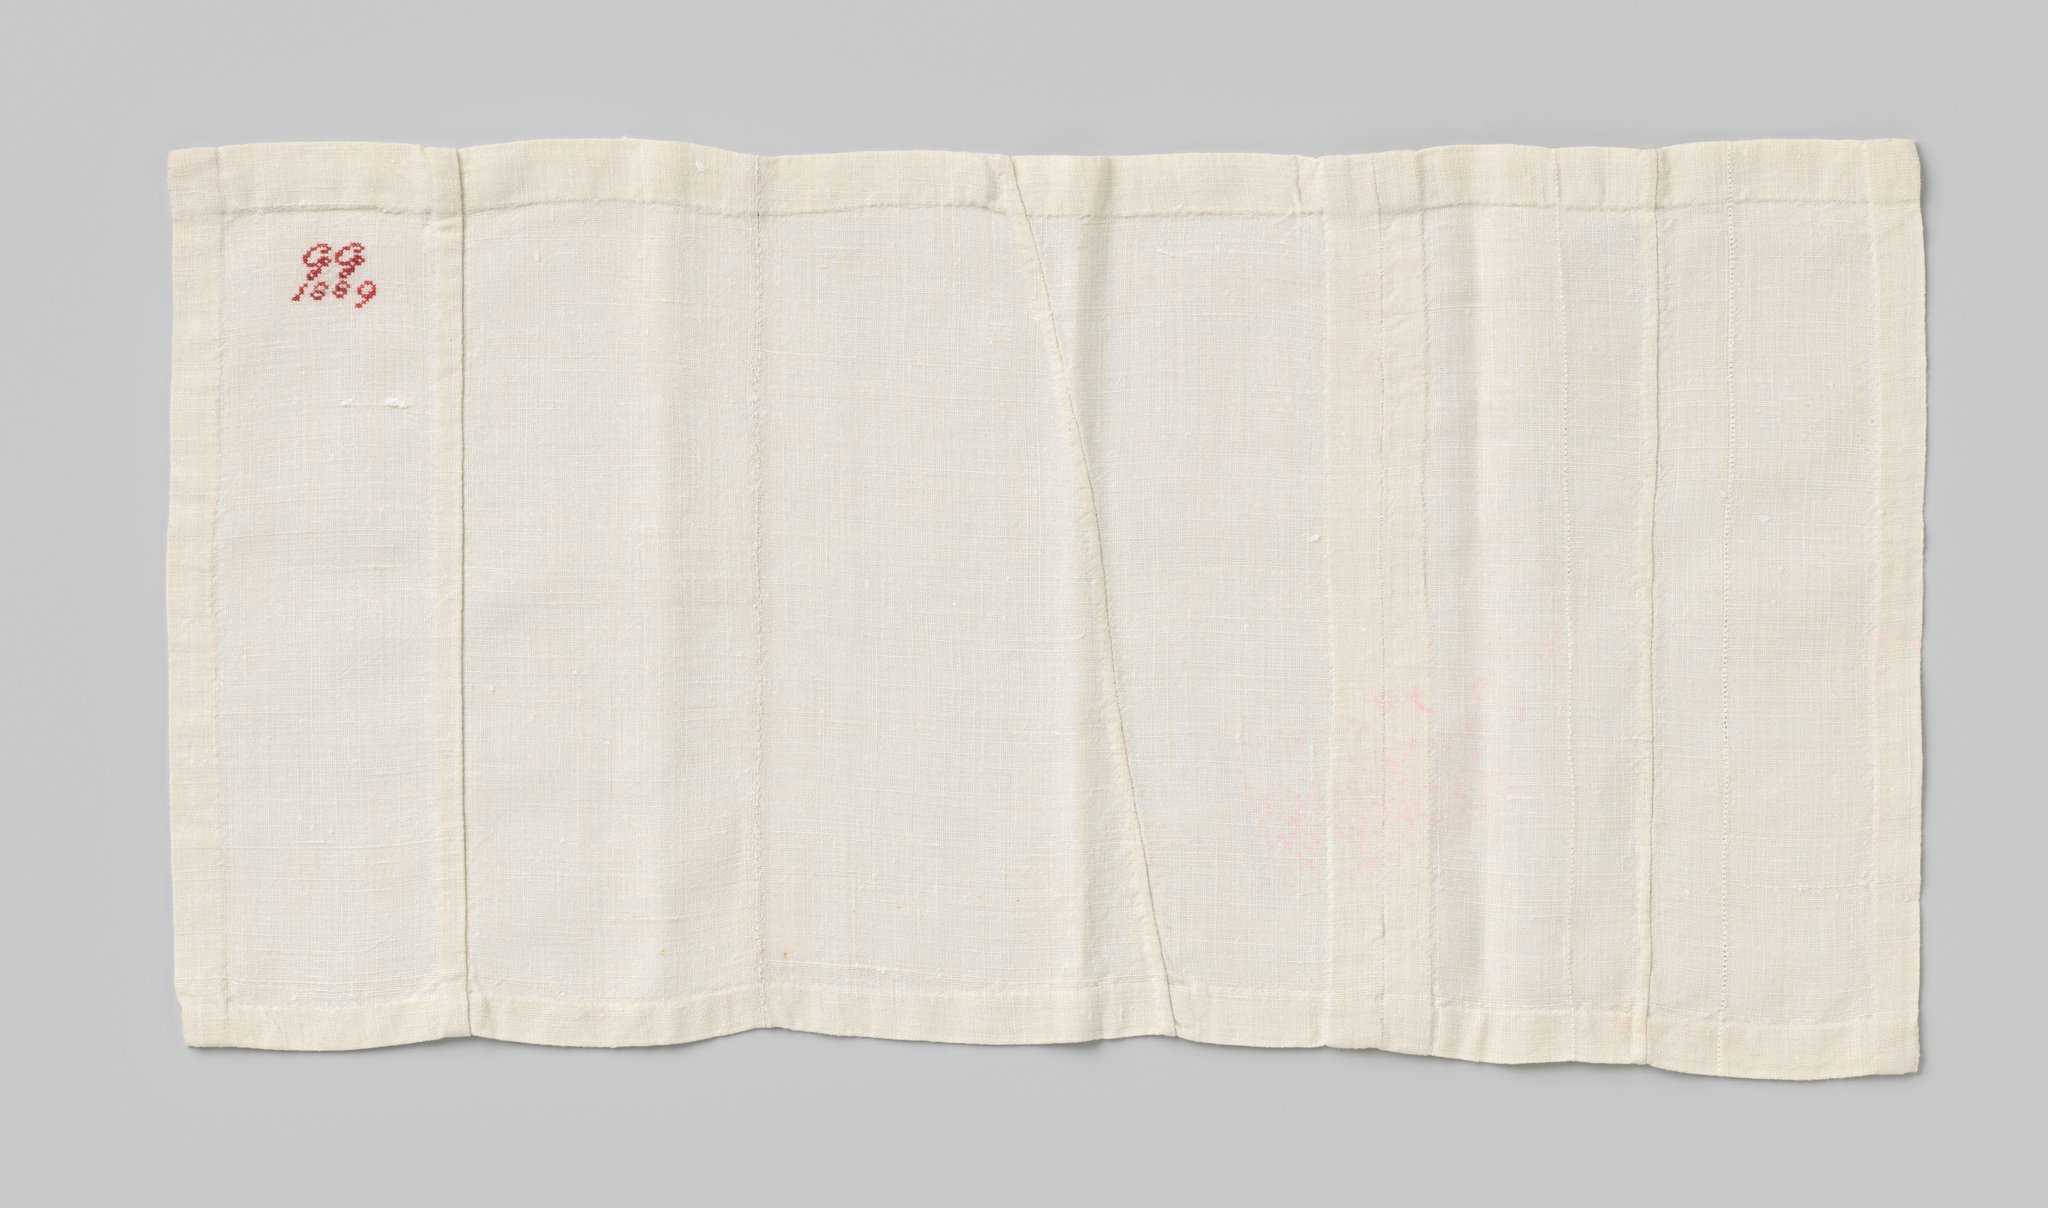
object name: handwerk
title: Naailap van linnen en katoen, gemerkt: GG 1889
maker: g. glas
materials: cotton, linen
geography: deventer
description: Naailap van linnen en katoen. Gemerkt. Vervaardigd op de Normaalschool te Deventer voor de akte `Nuttige handwerken'.